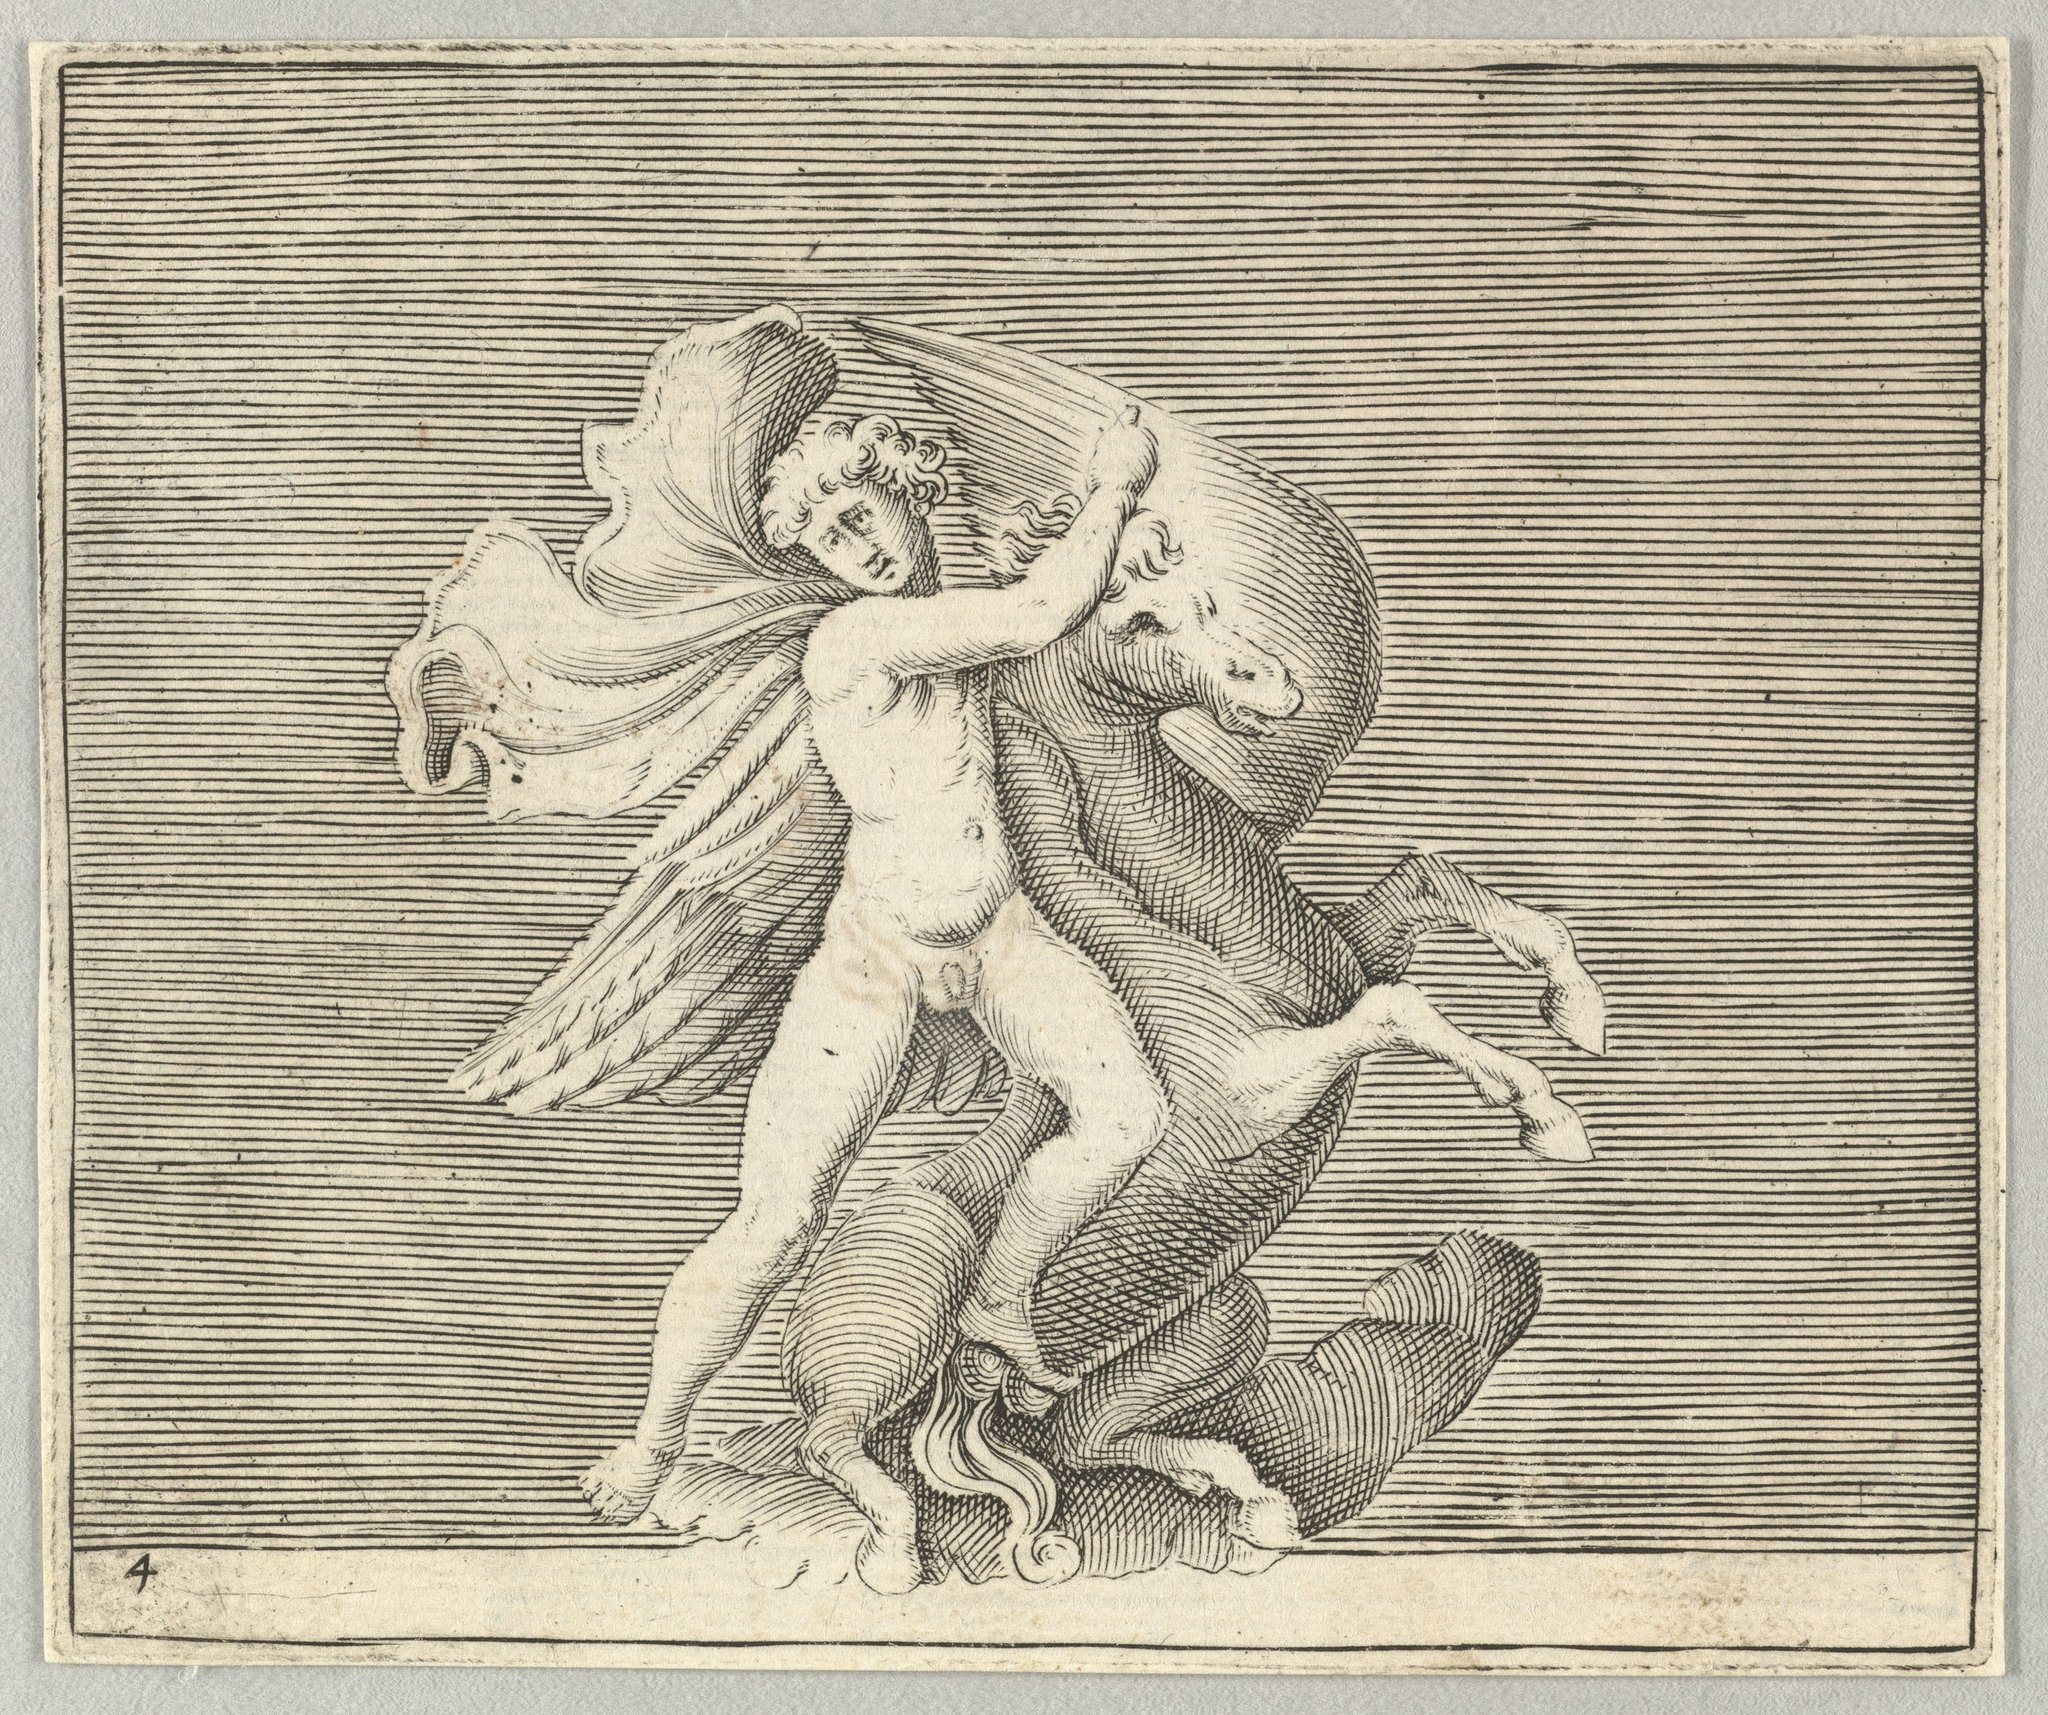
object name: print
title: Man Grappling with Winged Horse, from "Ex Antiquis Cameorum et Gemmae Delineata/ Liber Secundus/et ab Enea Vico Parmen Incis"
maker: anonymous, italian, 16th century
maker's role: artist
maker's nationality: italian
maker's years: 1500-1600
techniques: engraving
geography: rome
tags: male nudes,pegasus